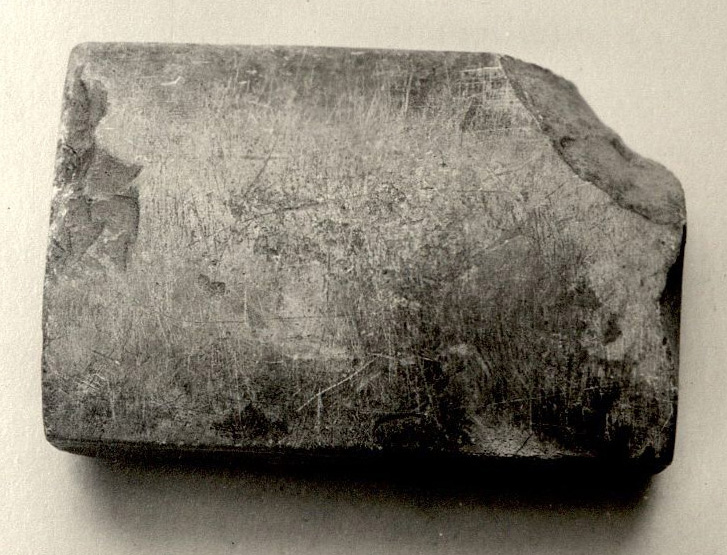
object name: weight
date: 1981-1640 BCE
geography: egypt